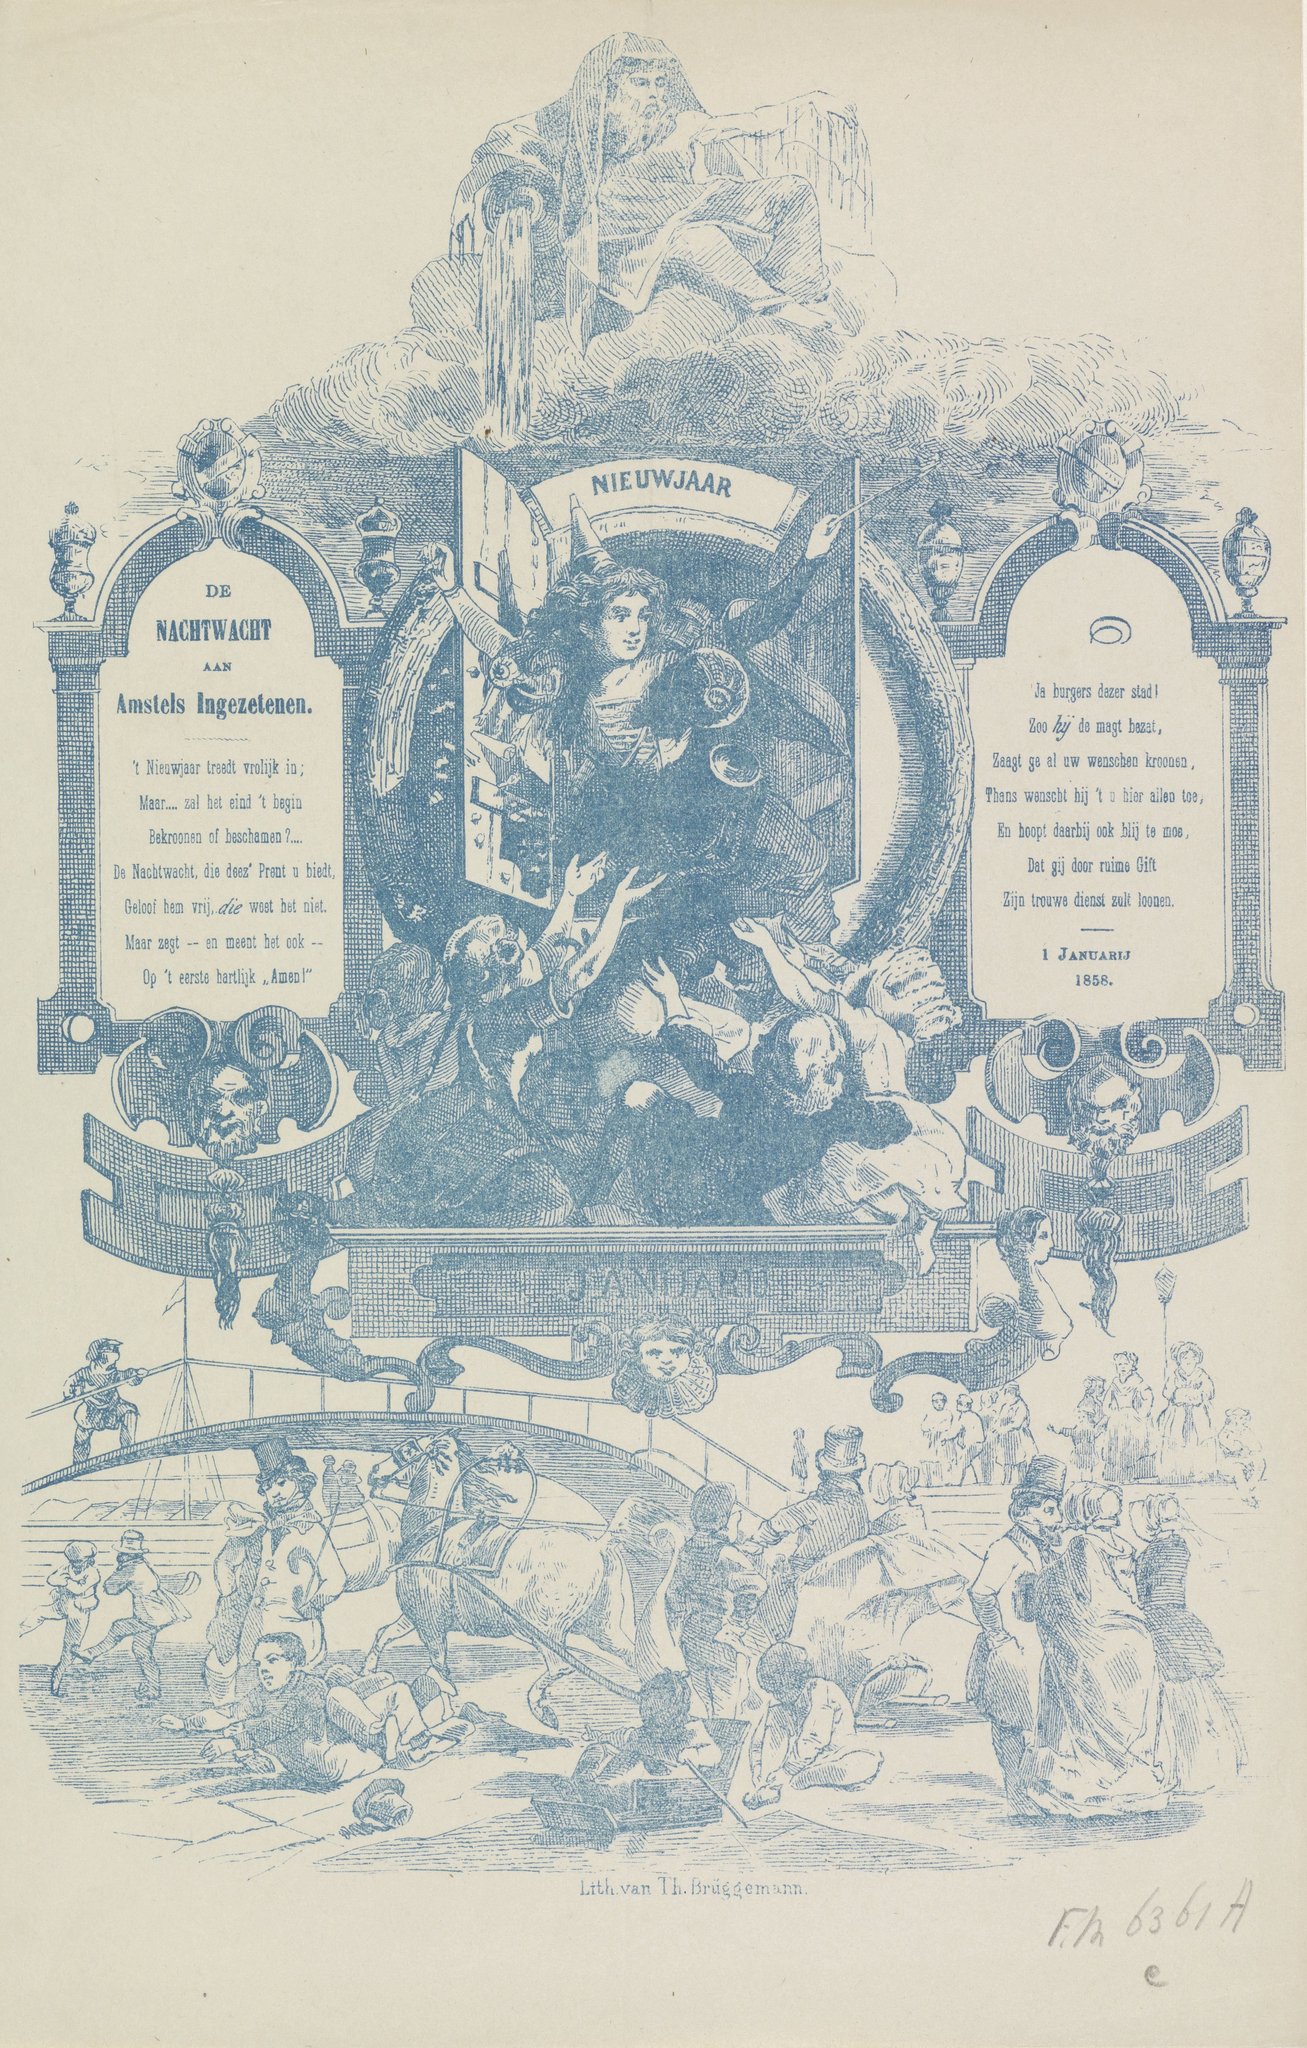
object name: print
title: De Nachtwacht aan Amstels Ingezetenen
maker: theodor brüggemann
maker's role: print maker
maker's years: 1822-1888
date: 1857-1858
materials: paper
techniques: printing, lithograph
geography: amsterdam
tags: night patrol, winter, 'hyems'; 'inverno' (ripa) (+ allegorical or symbolical representation of seasons and months), winter sports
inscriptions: collector's mark: Lugt 2228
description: Nieuwjaarswens van de Amsterdamse nachtwacht (ratelwacht) voor het jaar 1858. Een jonge vrouw, de personificatie van het nieuwe jaar, gooit de luiken open, daaronder kinderen met uitgestrekte armen. Links en rechts een vers. Bovenaan koning Winter, onderaan ijsvermaak.